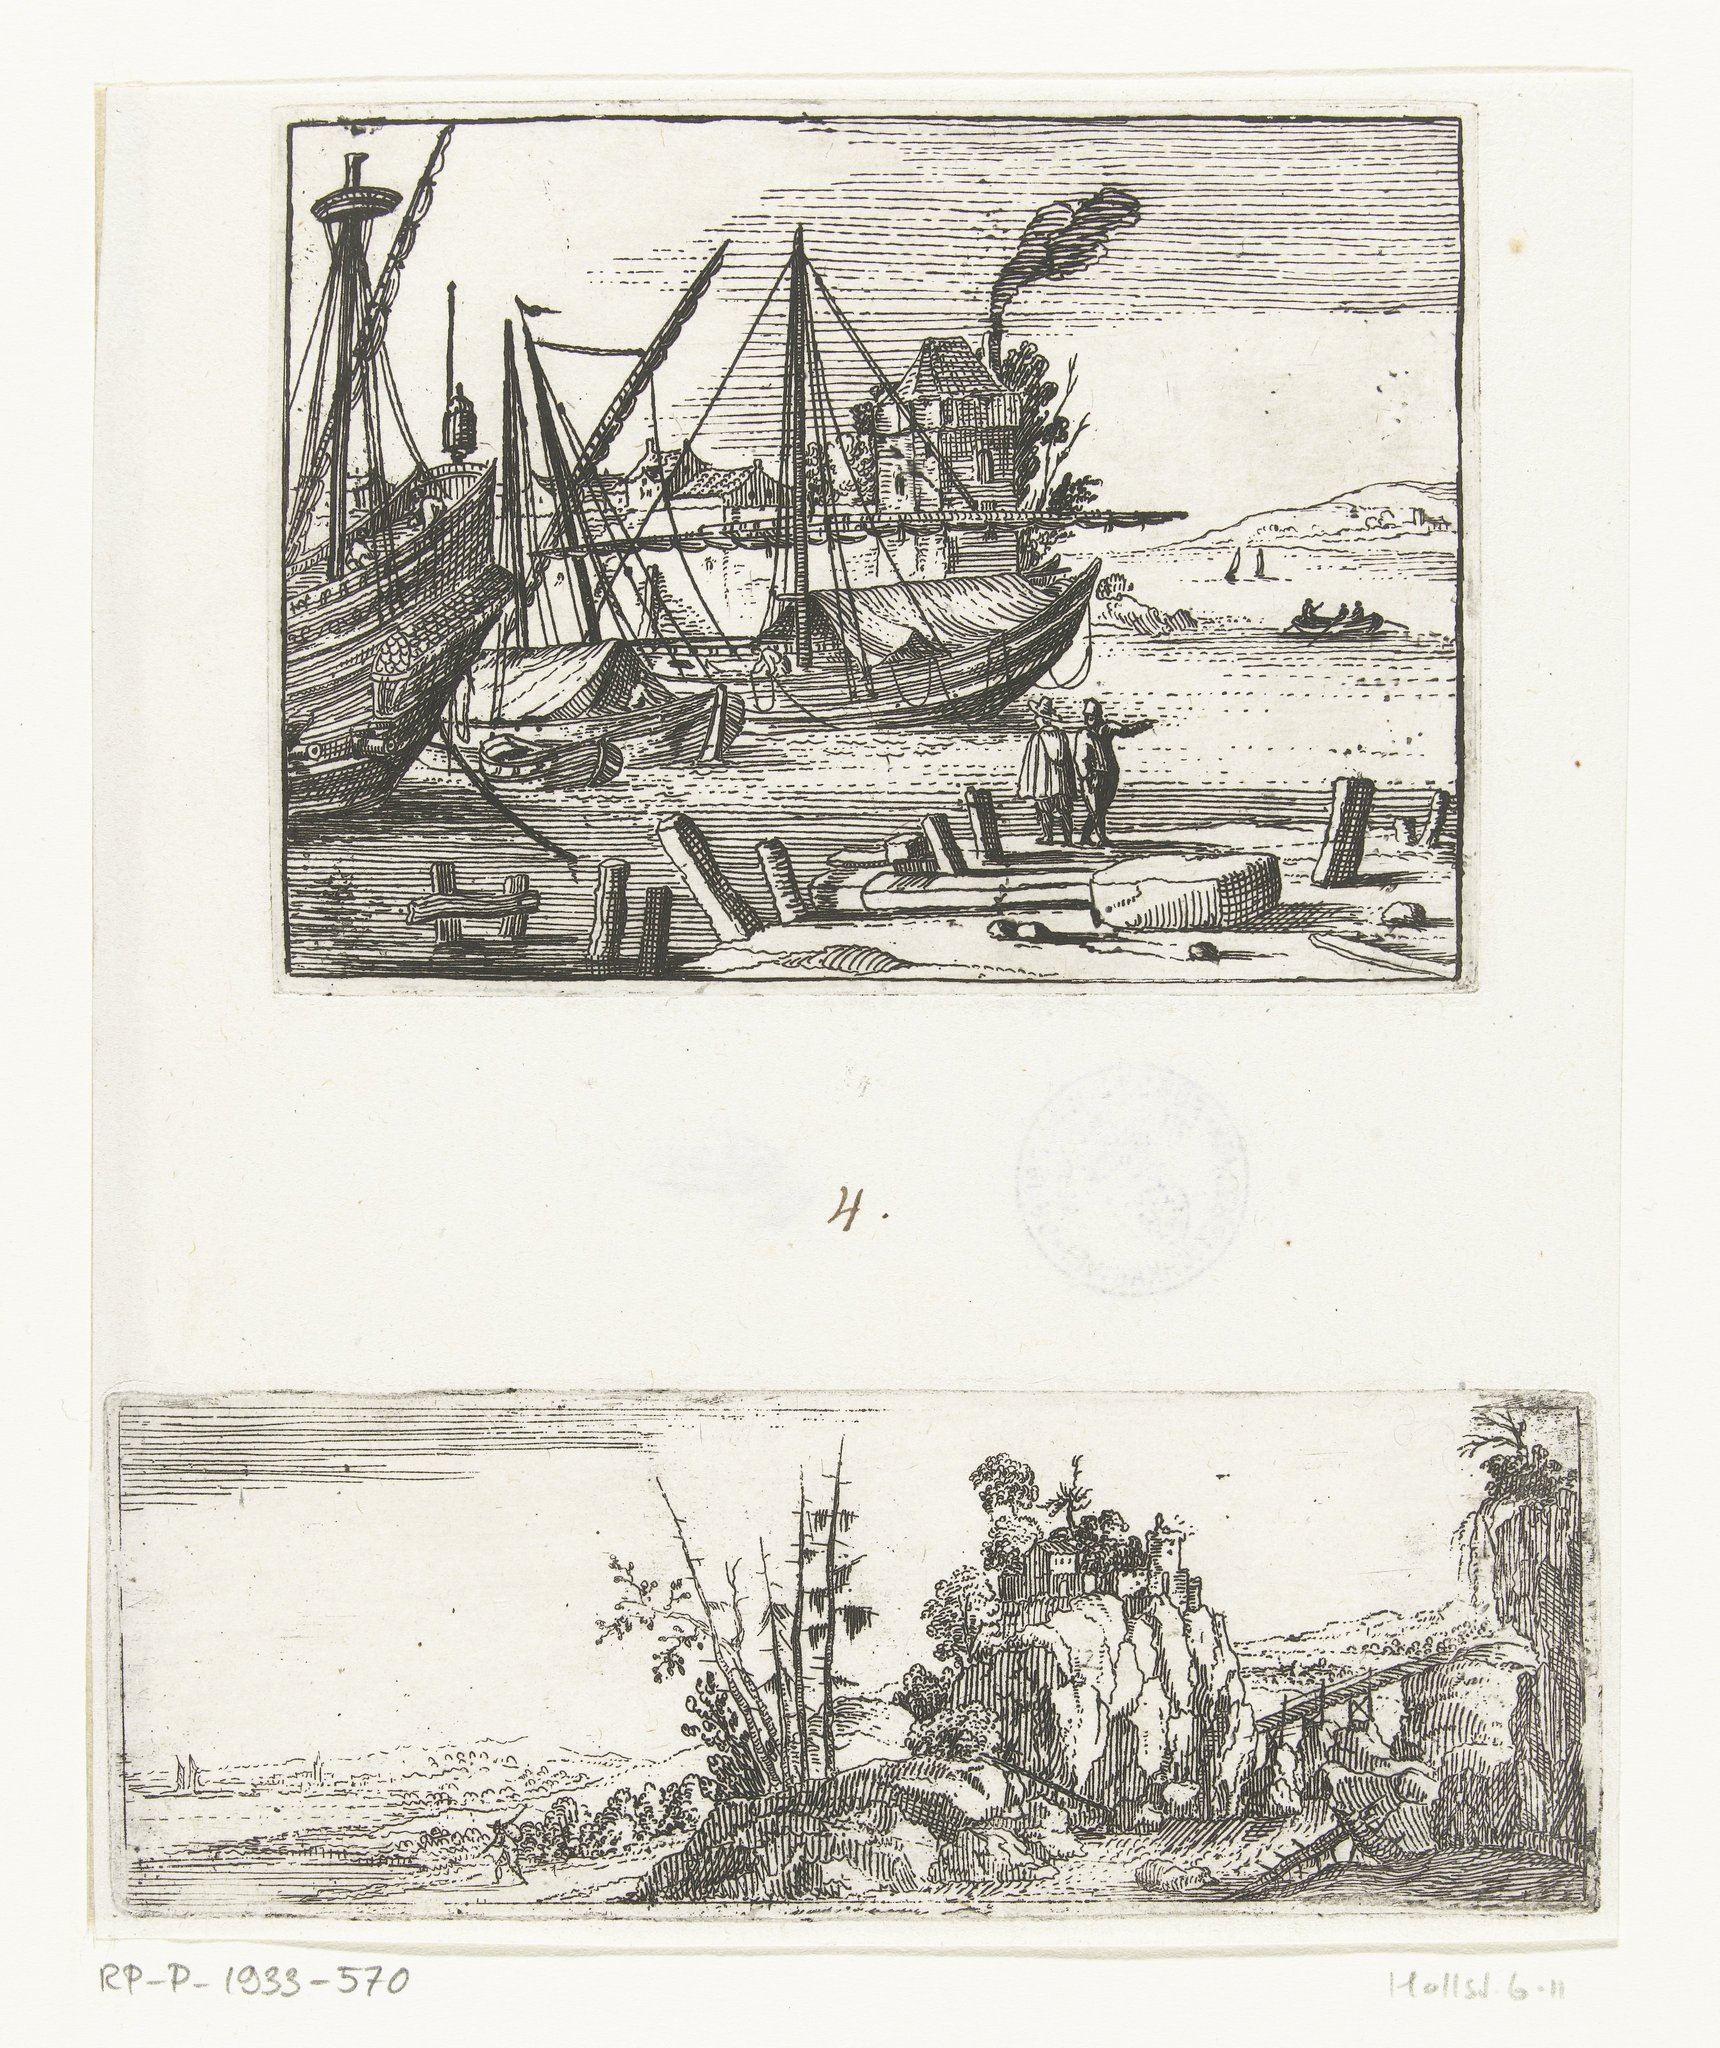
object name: print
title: Landschappen en marines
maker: cornelis bol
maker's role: print maker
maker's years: 1589-1666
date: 1615-1666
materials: paper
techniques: etching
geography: netherlands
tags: water course, sea (seascape), rocks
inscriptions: collector's mark: Lugt 2542, number: ‘4.’, collector's mark: Lugt 2228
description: Twee platen afgedrukt op een vel papier. Boven een havengezicht met twee zeilschepen en een galjoen, twee mannen staan op de kade. Onder een rotsachtig landschap met bruggen. Een wandelaar loopt langs de waterkant.